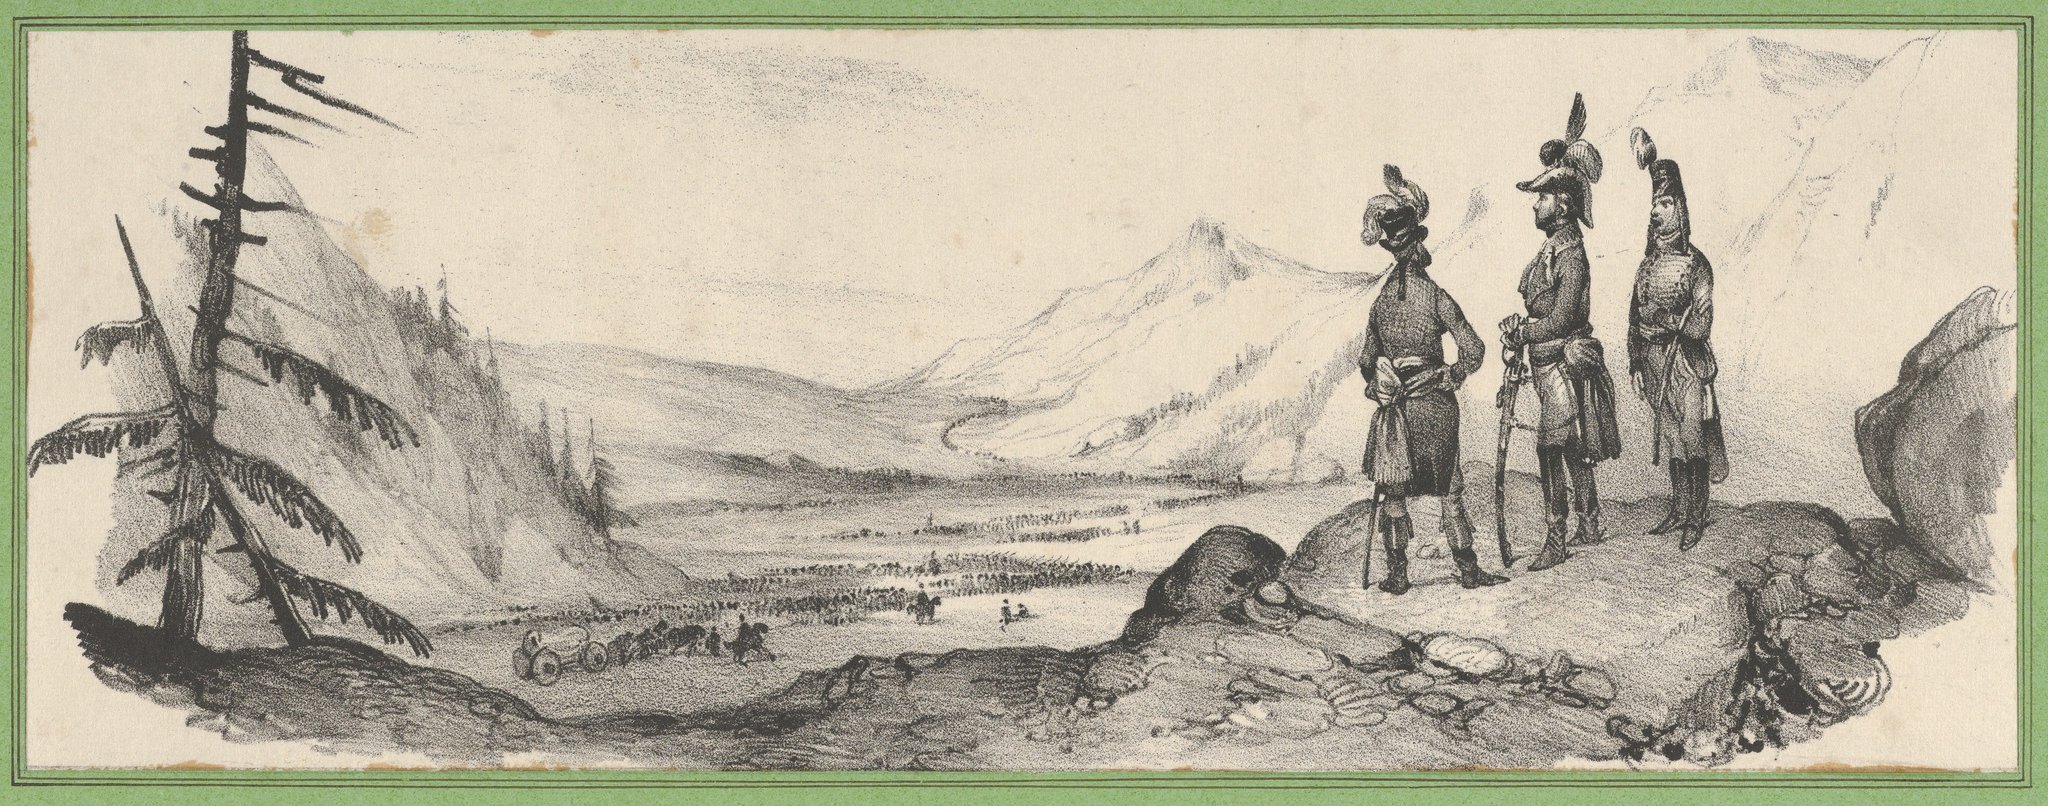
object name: print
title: Three soldiers in a landscape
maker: victor adam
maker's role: artist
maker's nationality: french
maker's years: 1801-1866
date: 1834-1866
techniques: lithograph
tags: soldiers,landscapes